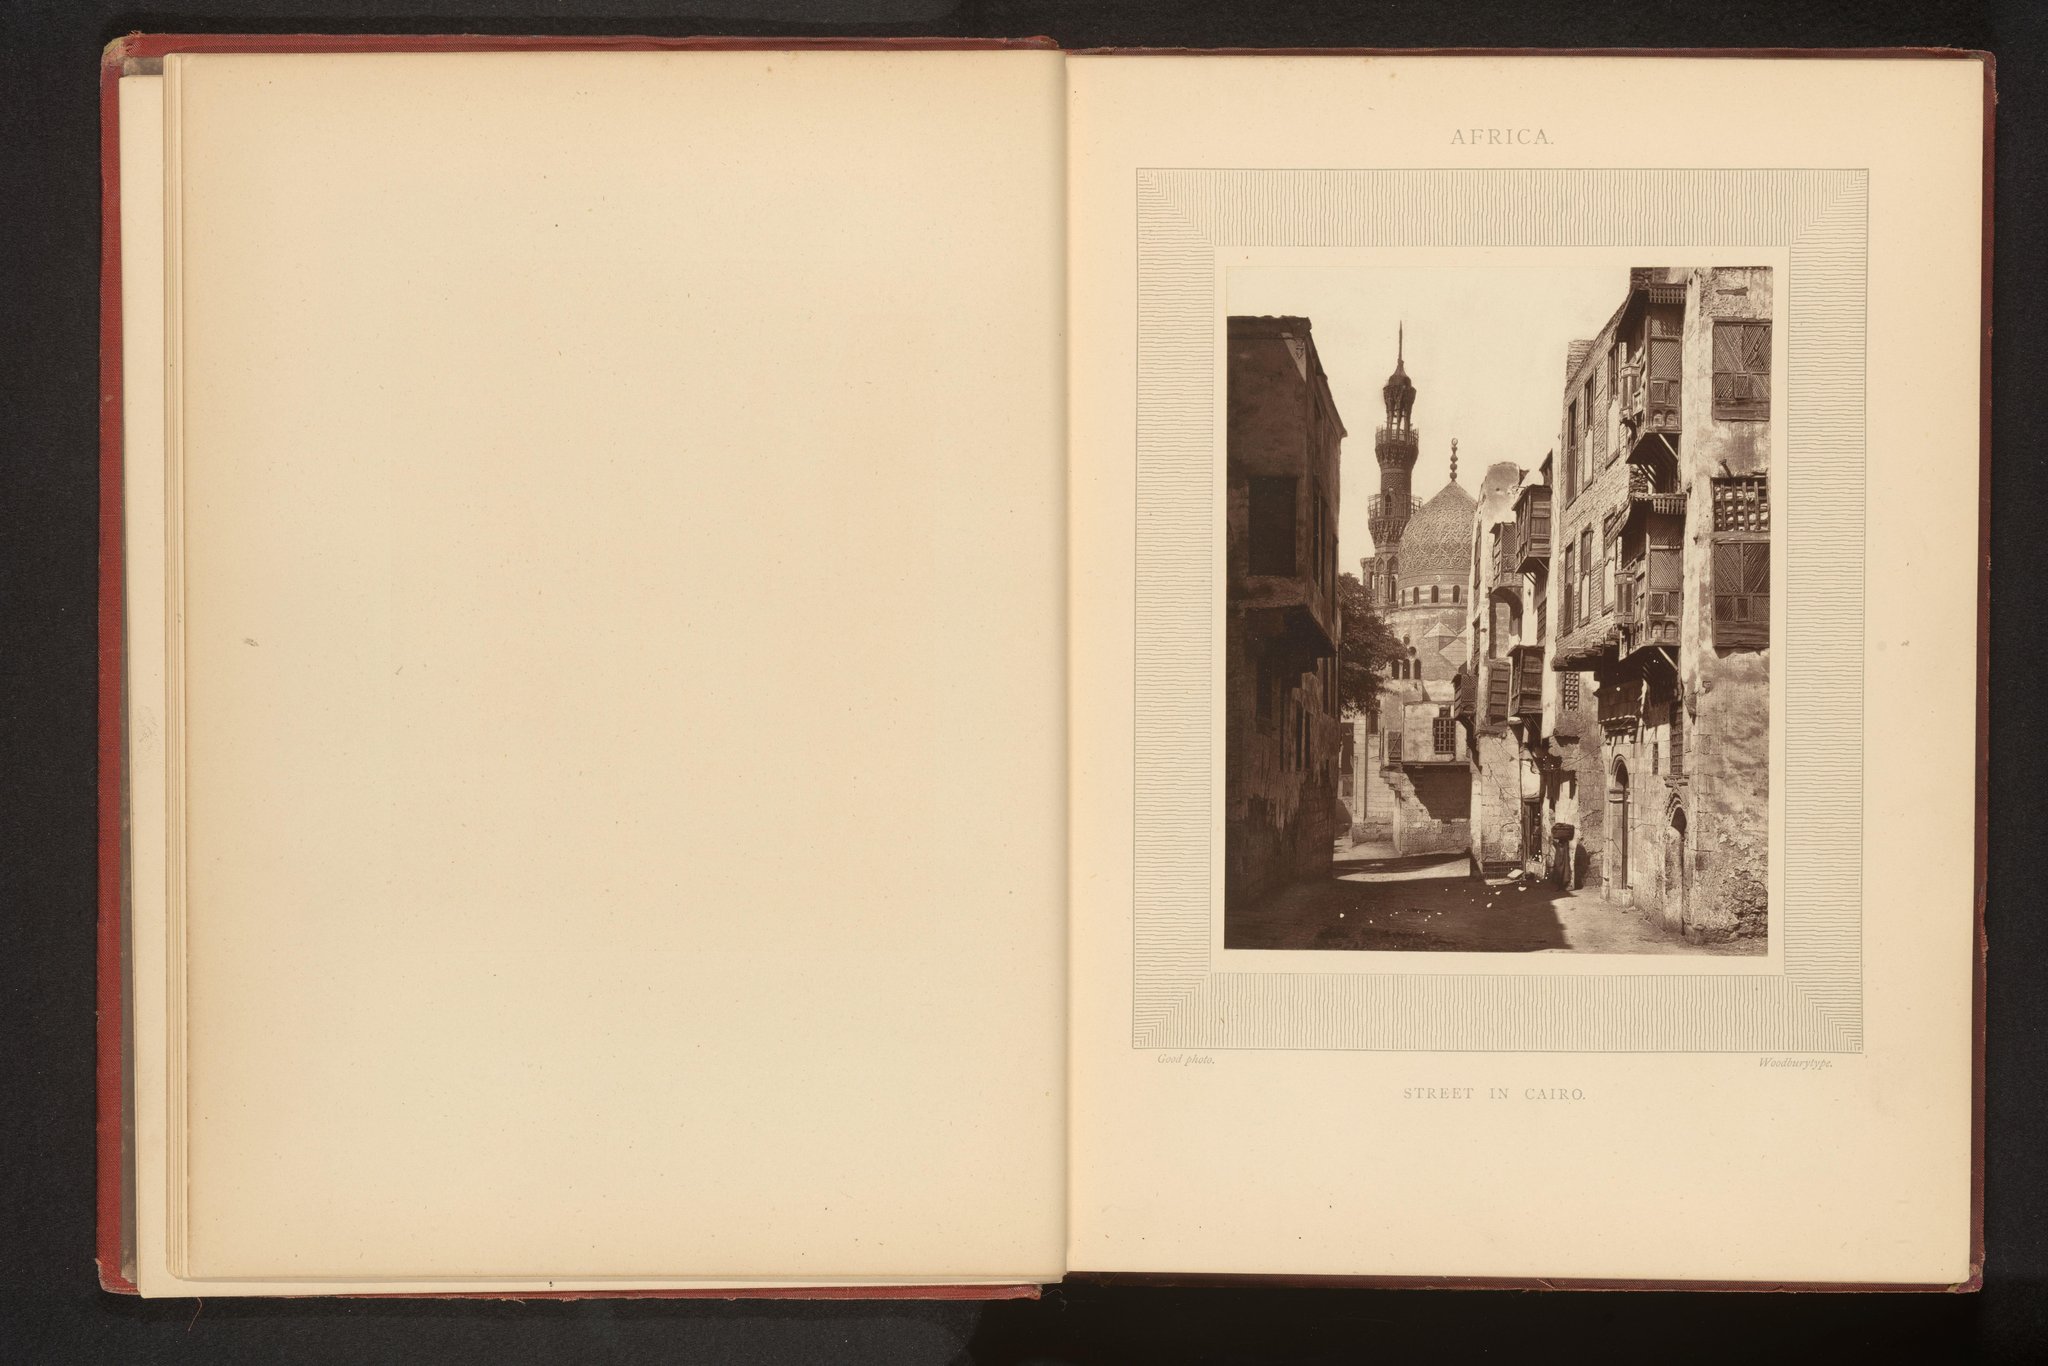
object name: photomechanical print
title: Straatgezicht in Caïro met het mausoleum van Sultan al-Ashraf Qaytbay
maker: frank mason good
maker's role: publisher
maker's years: 1839-1928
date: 1870-1875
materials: cardboard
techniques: woodburytype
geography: cairo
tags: palace, street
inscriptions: inscription: ‘Good photo.’, inscription: ‘Africa’